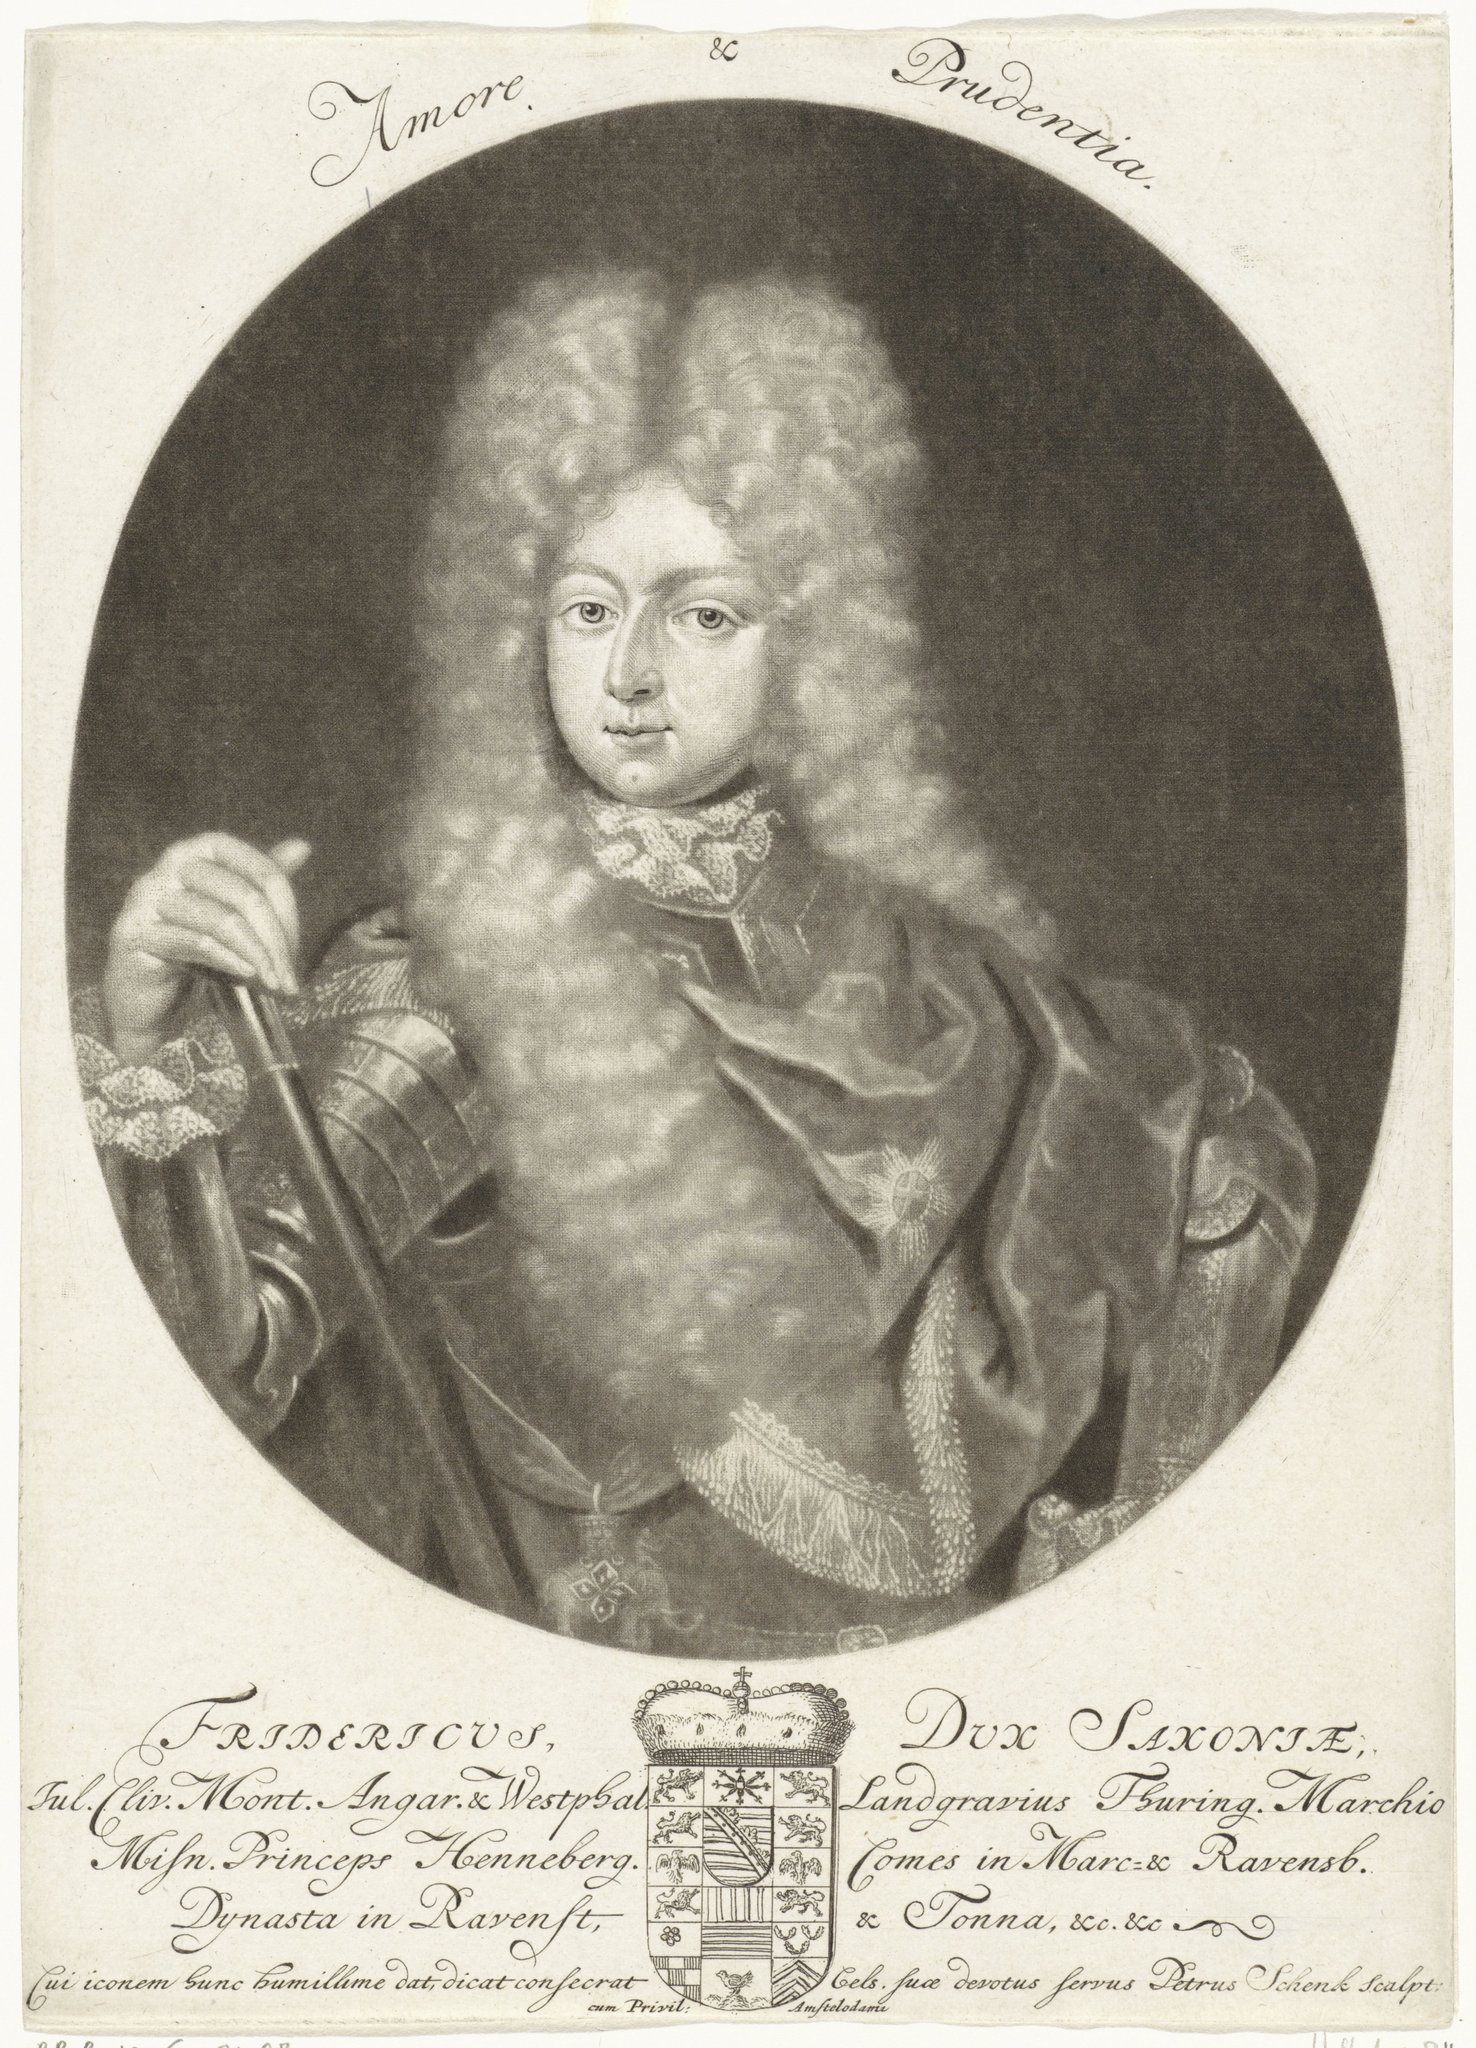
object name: print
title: Portret van Frederik II, hertog van Saksen-Gotha-Altenburg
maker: pieter schenk (i)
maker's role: print maker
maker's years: 1660-1711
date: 1670-1713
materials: paper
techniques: engraving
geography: amsterdam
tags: armour, wig, armorial bearing, heraldry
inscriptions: collector's mark: Lugt 2228